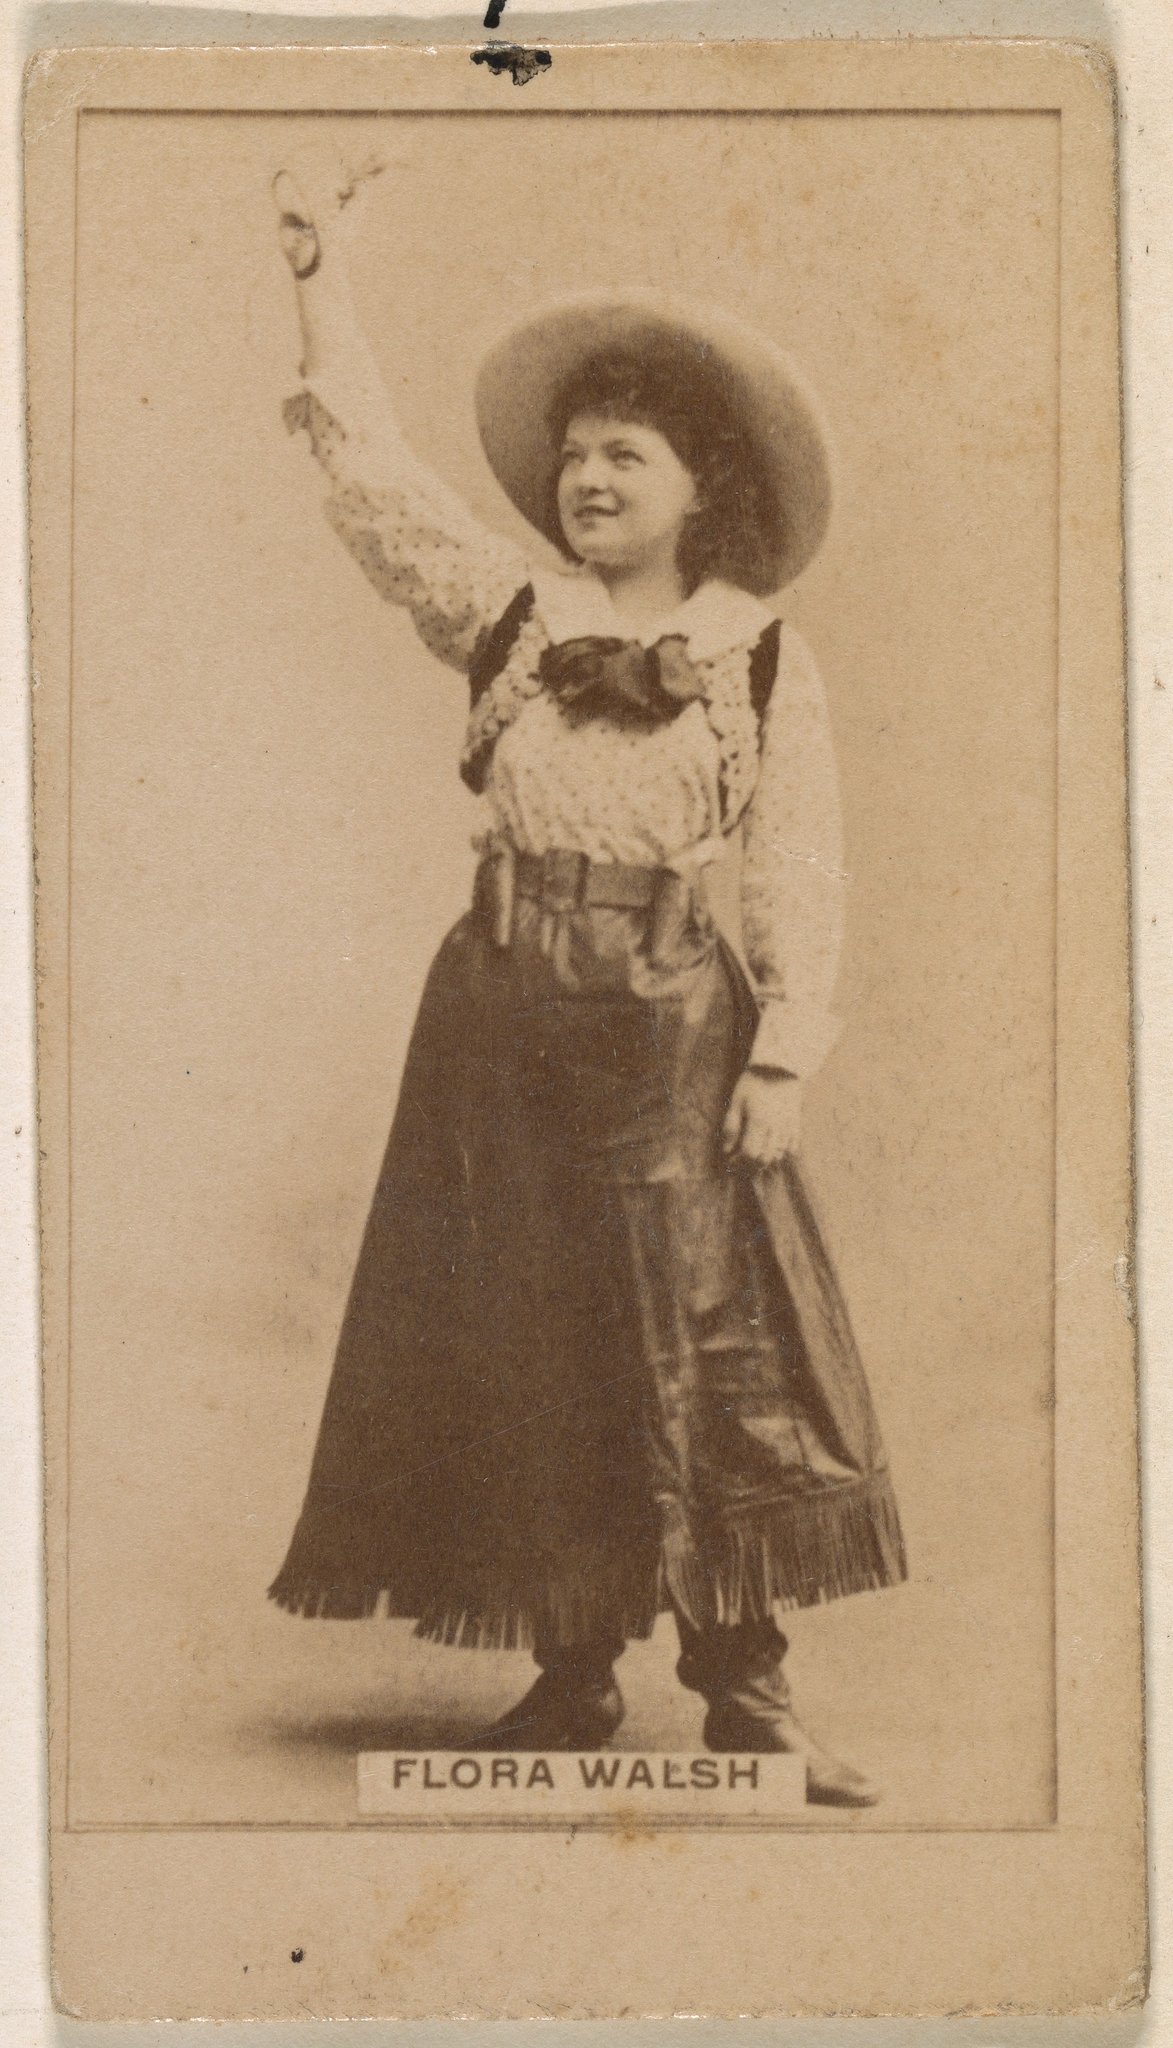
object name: photograph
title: Flora Walsh, from the Actresses series (N245) issued by Kinney Brothers to promote Sweet Caporal Cigarettes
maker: kinney brothers tobacco company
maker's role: publisher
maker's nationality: american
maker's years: 1869-2011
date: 1890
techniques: albumen silver print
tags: portraits,women,actresses